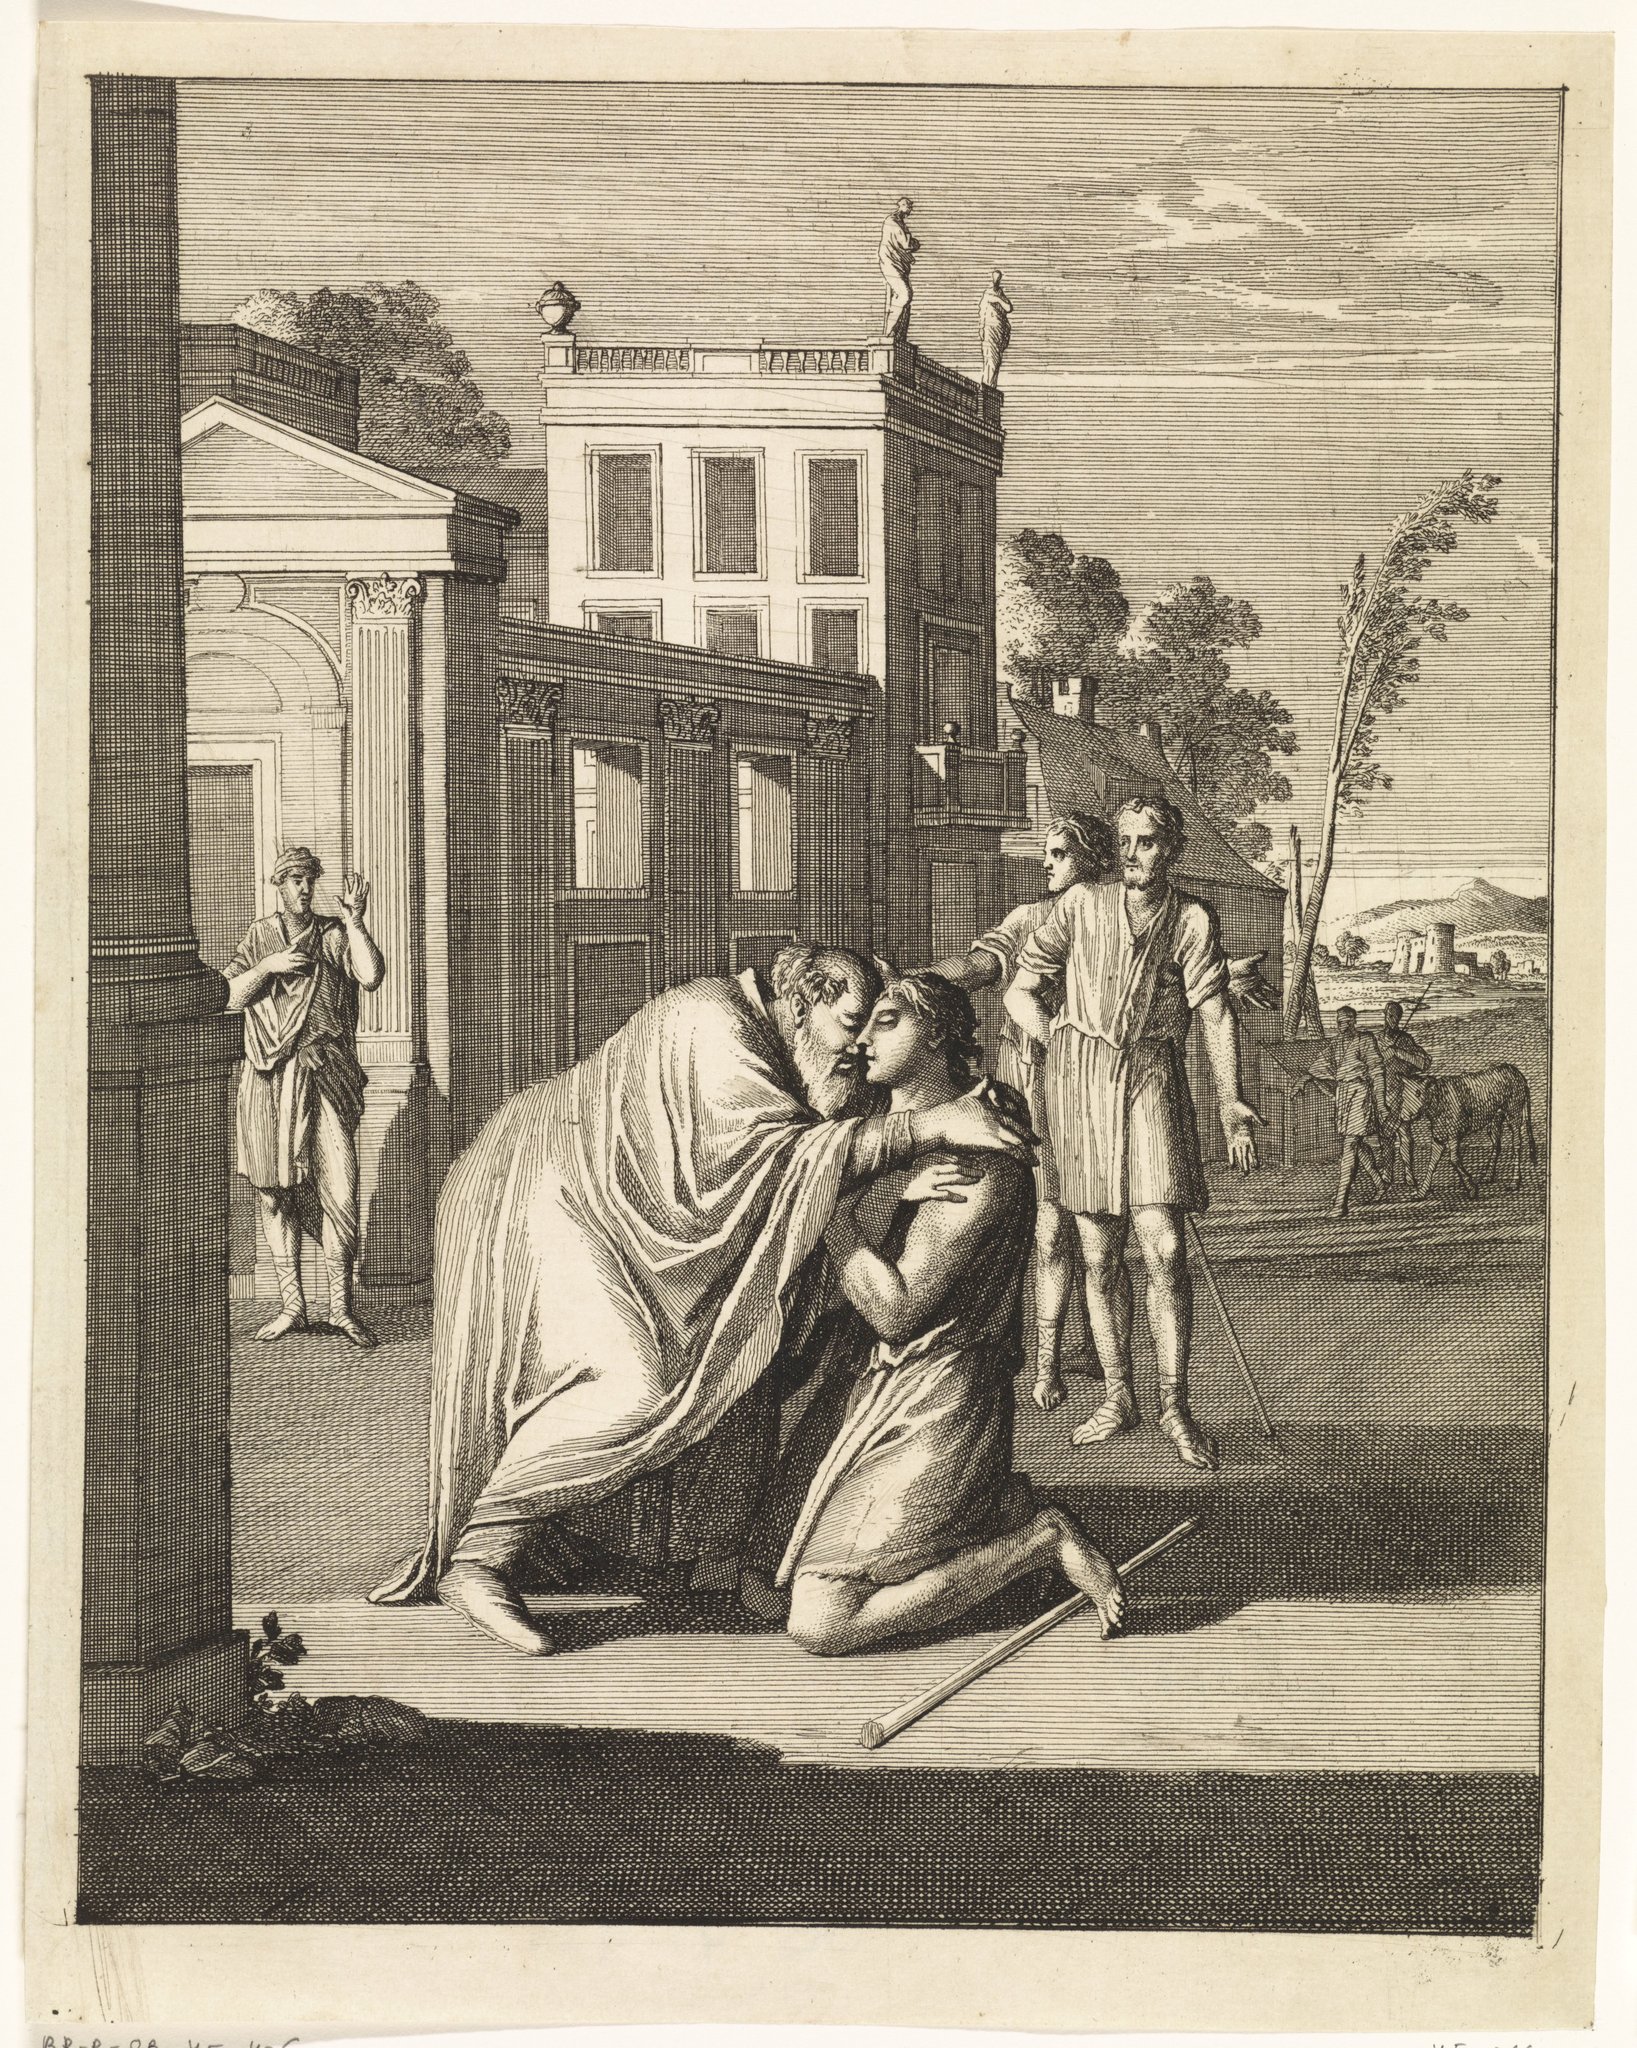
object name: print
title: Thuiskomst van de verloren zoon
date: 1708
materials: paper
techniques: etching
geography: nuremberg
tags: the parable of the prodigal son (luke 15:11-32)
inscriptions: collector's mark: Lugt 2228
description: Proefdruk van een prent welke is opgenomen als illustratie in: Historiae Celebriores Veteris Testamenti. Christoph Weigel, 1708.